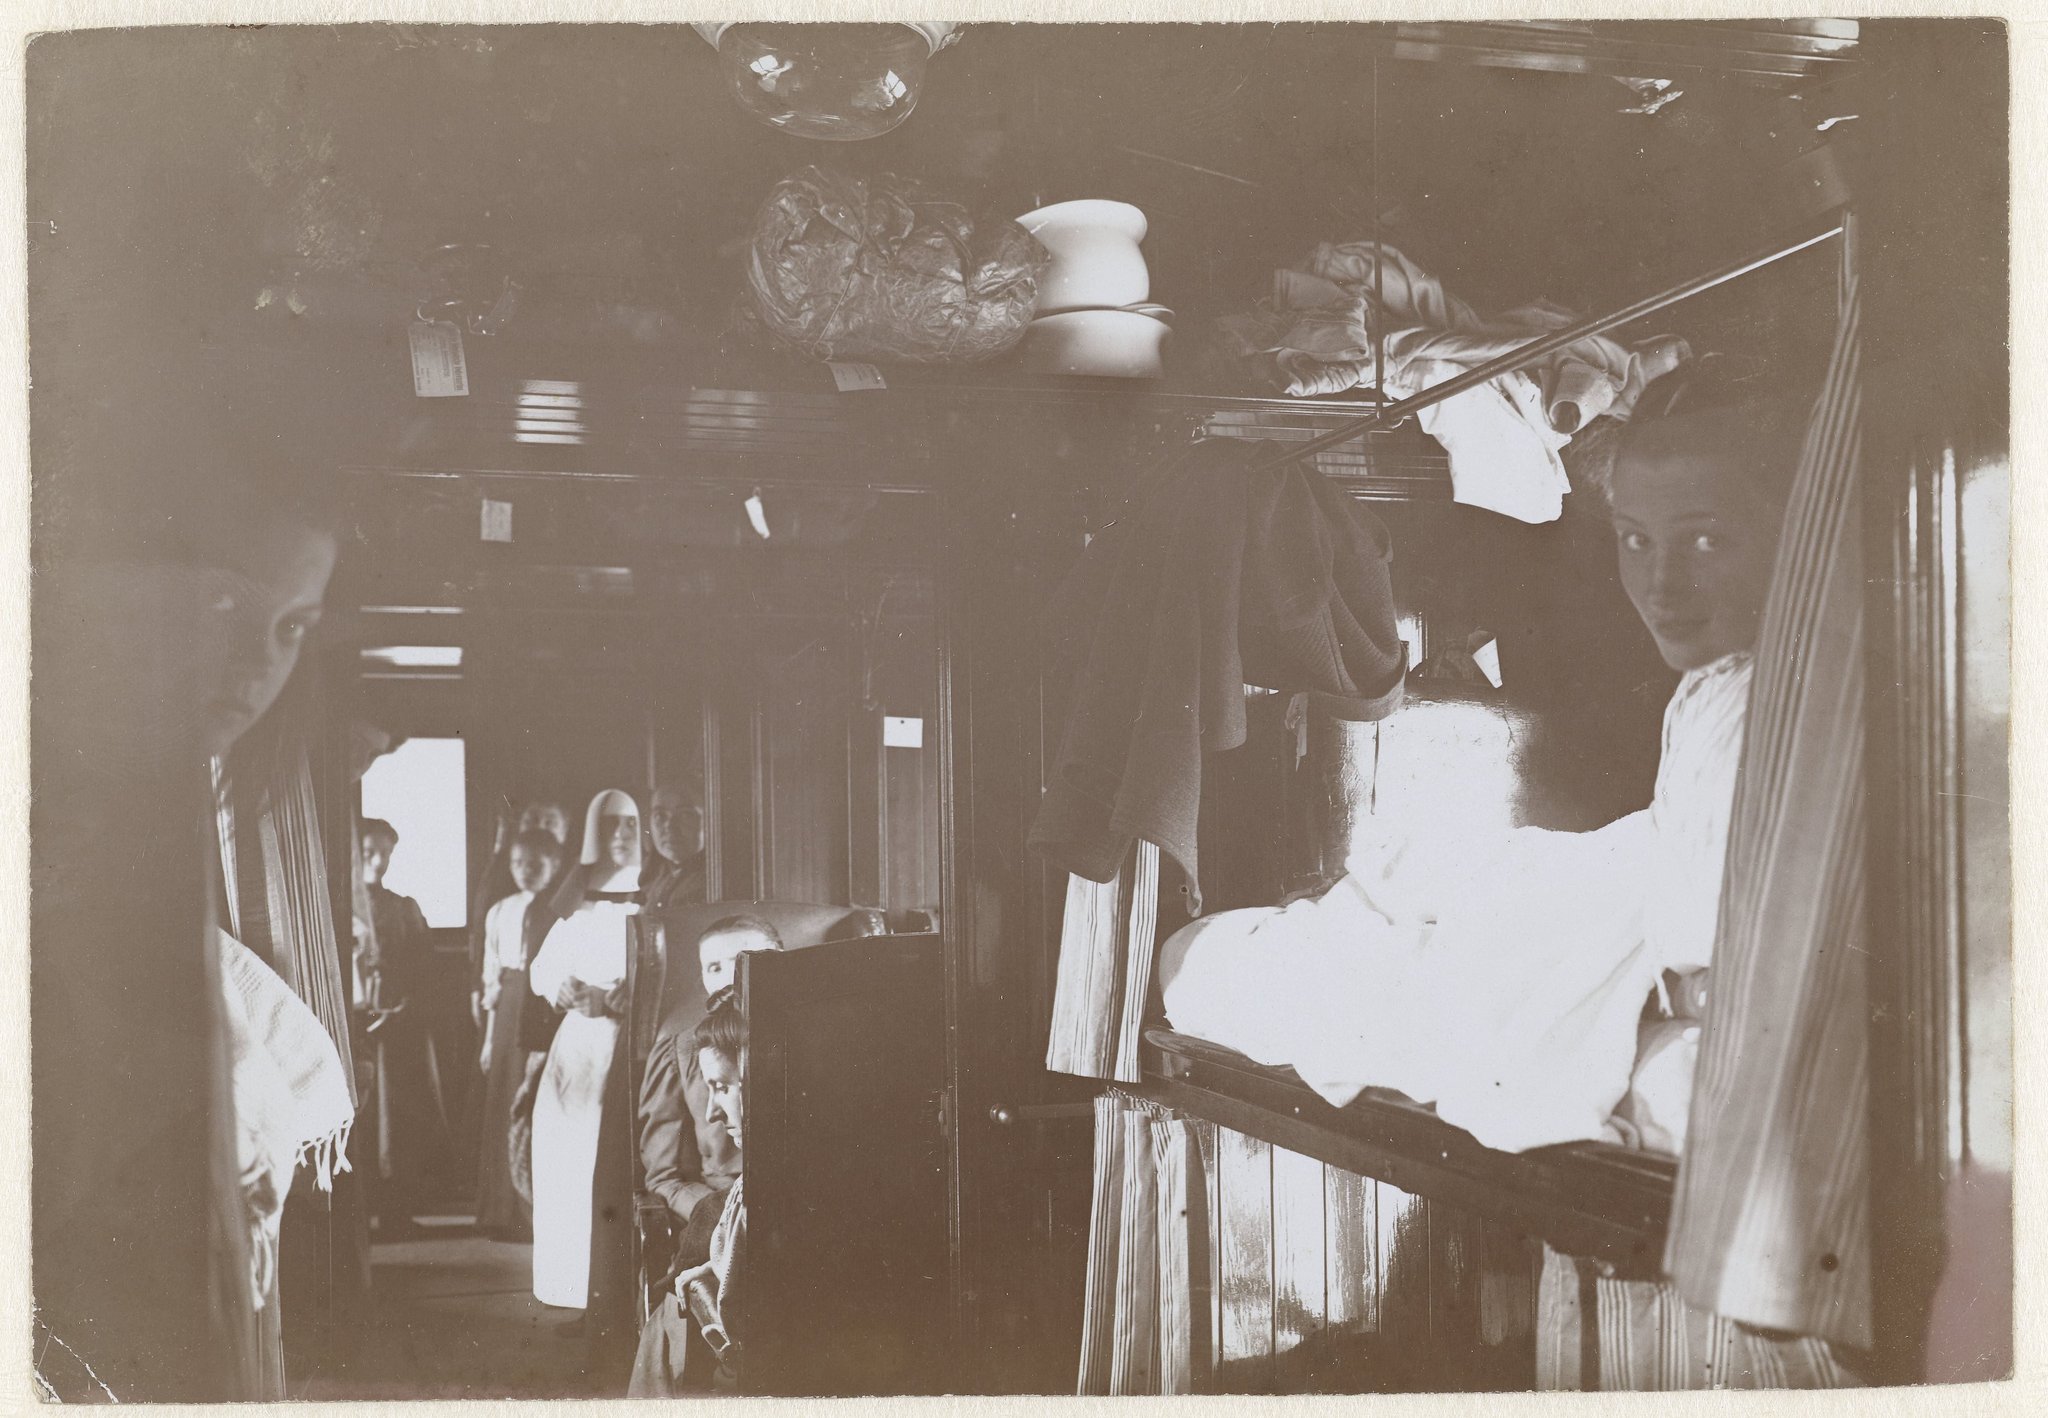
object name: photograph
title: Pelgrims in een trein naar Lourdes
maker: Anonymous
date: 1880-1910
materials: paper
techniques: collodion silver print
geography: france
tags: railway-coach, railway-carriage, wagon